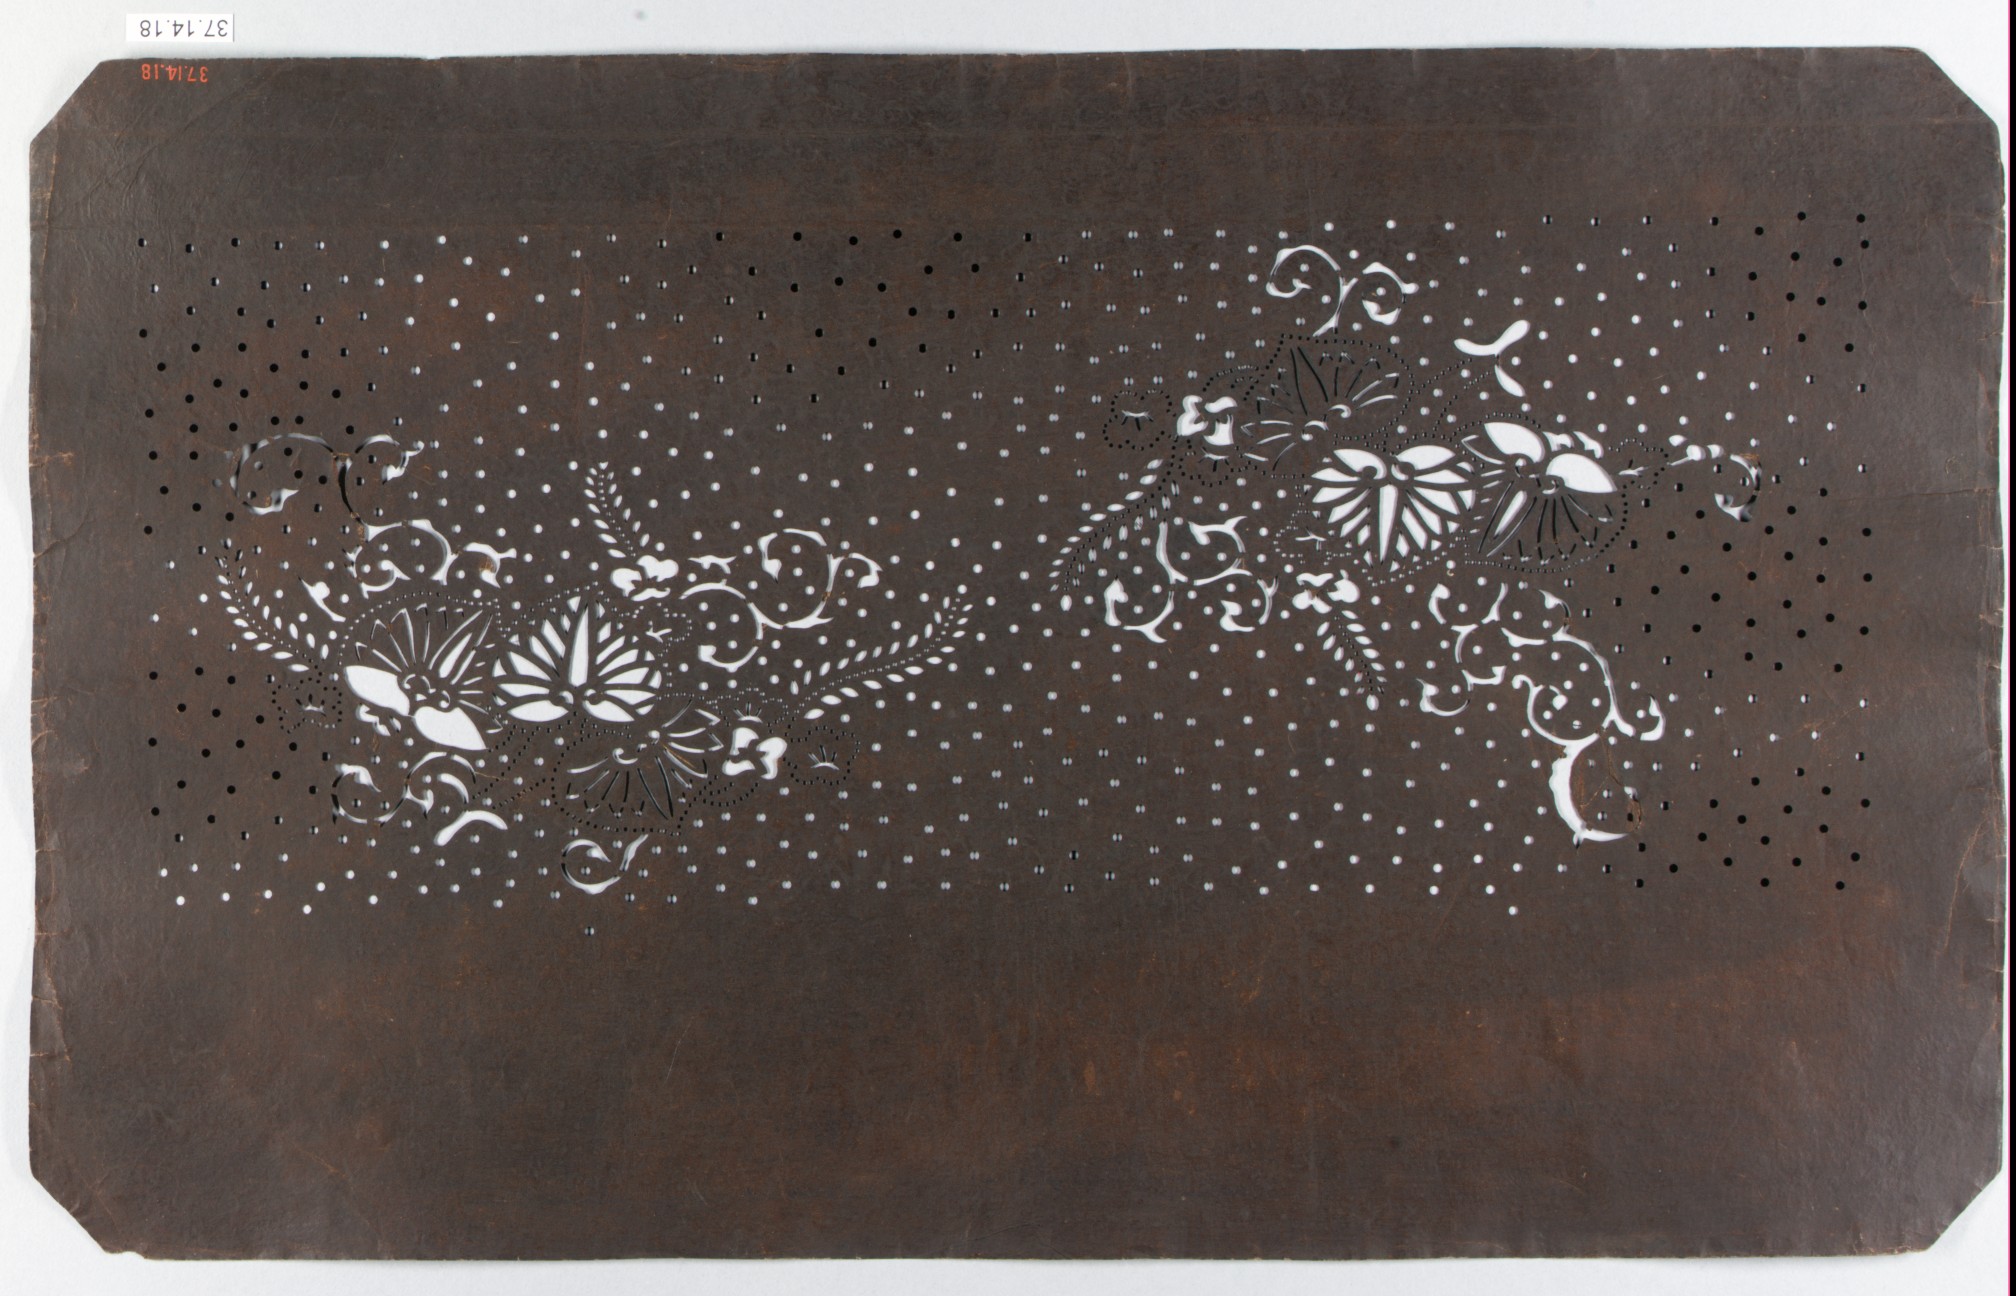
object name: stencil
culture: japanese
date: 1801-1833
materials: paper